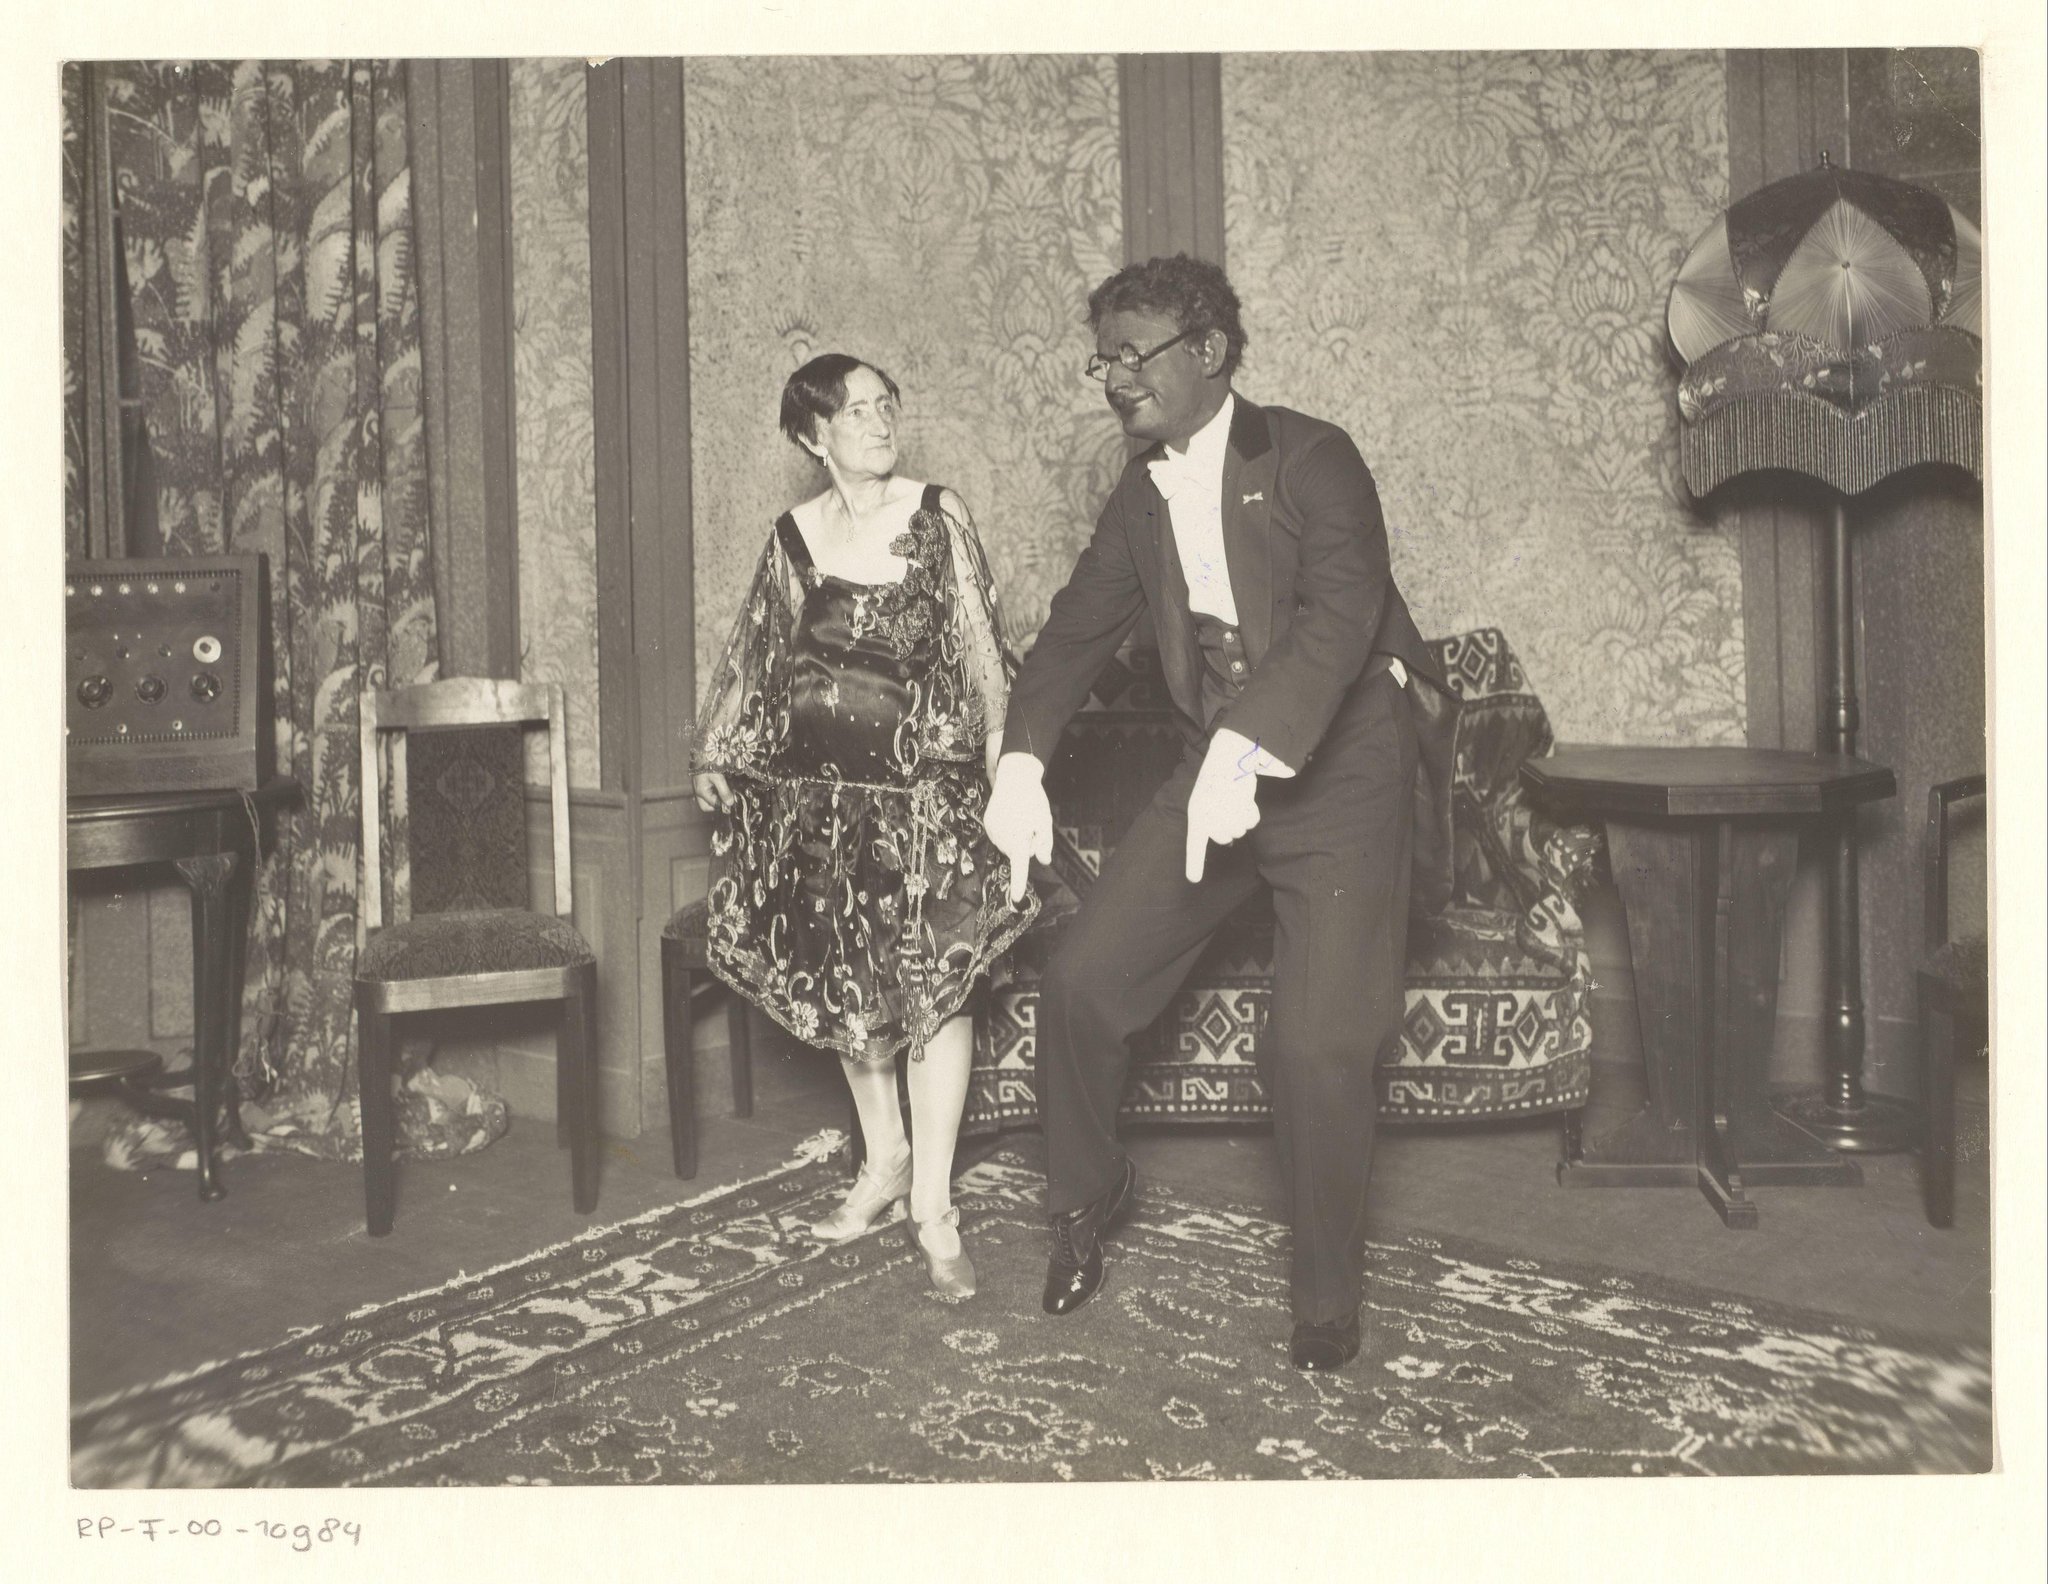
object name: photograph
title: Opvoering van het toneelstuk 'De tante uit Indië' van Henri van Wermeskerken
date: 1928-1970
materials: photographic support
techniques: gelatin silver print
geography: amsterdam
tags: theatre, theatrical performance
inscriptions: collector's mark: Lugt 2228a, annotation: ‘Toneelstuk/ De Tante uit Indië’, copyright notice: ‘COPYRIGHT/ N.V. VEREENIGDE FOTOBUREAUX/ NIEUWE HEERENGRACHT 105/ AMSTERDAM’, :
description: Een man en vrouw in avondkleding staan in een interieur. De man toont de vrouw een danspas en wijst naar zijn rechtervoet.